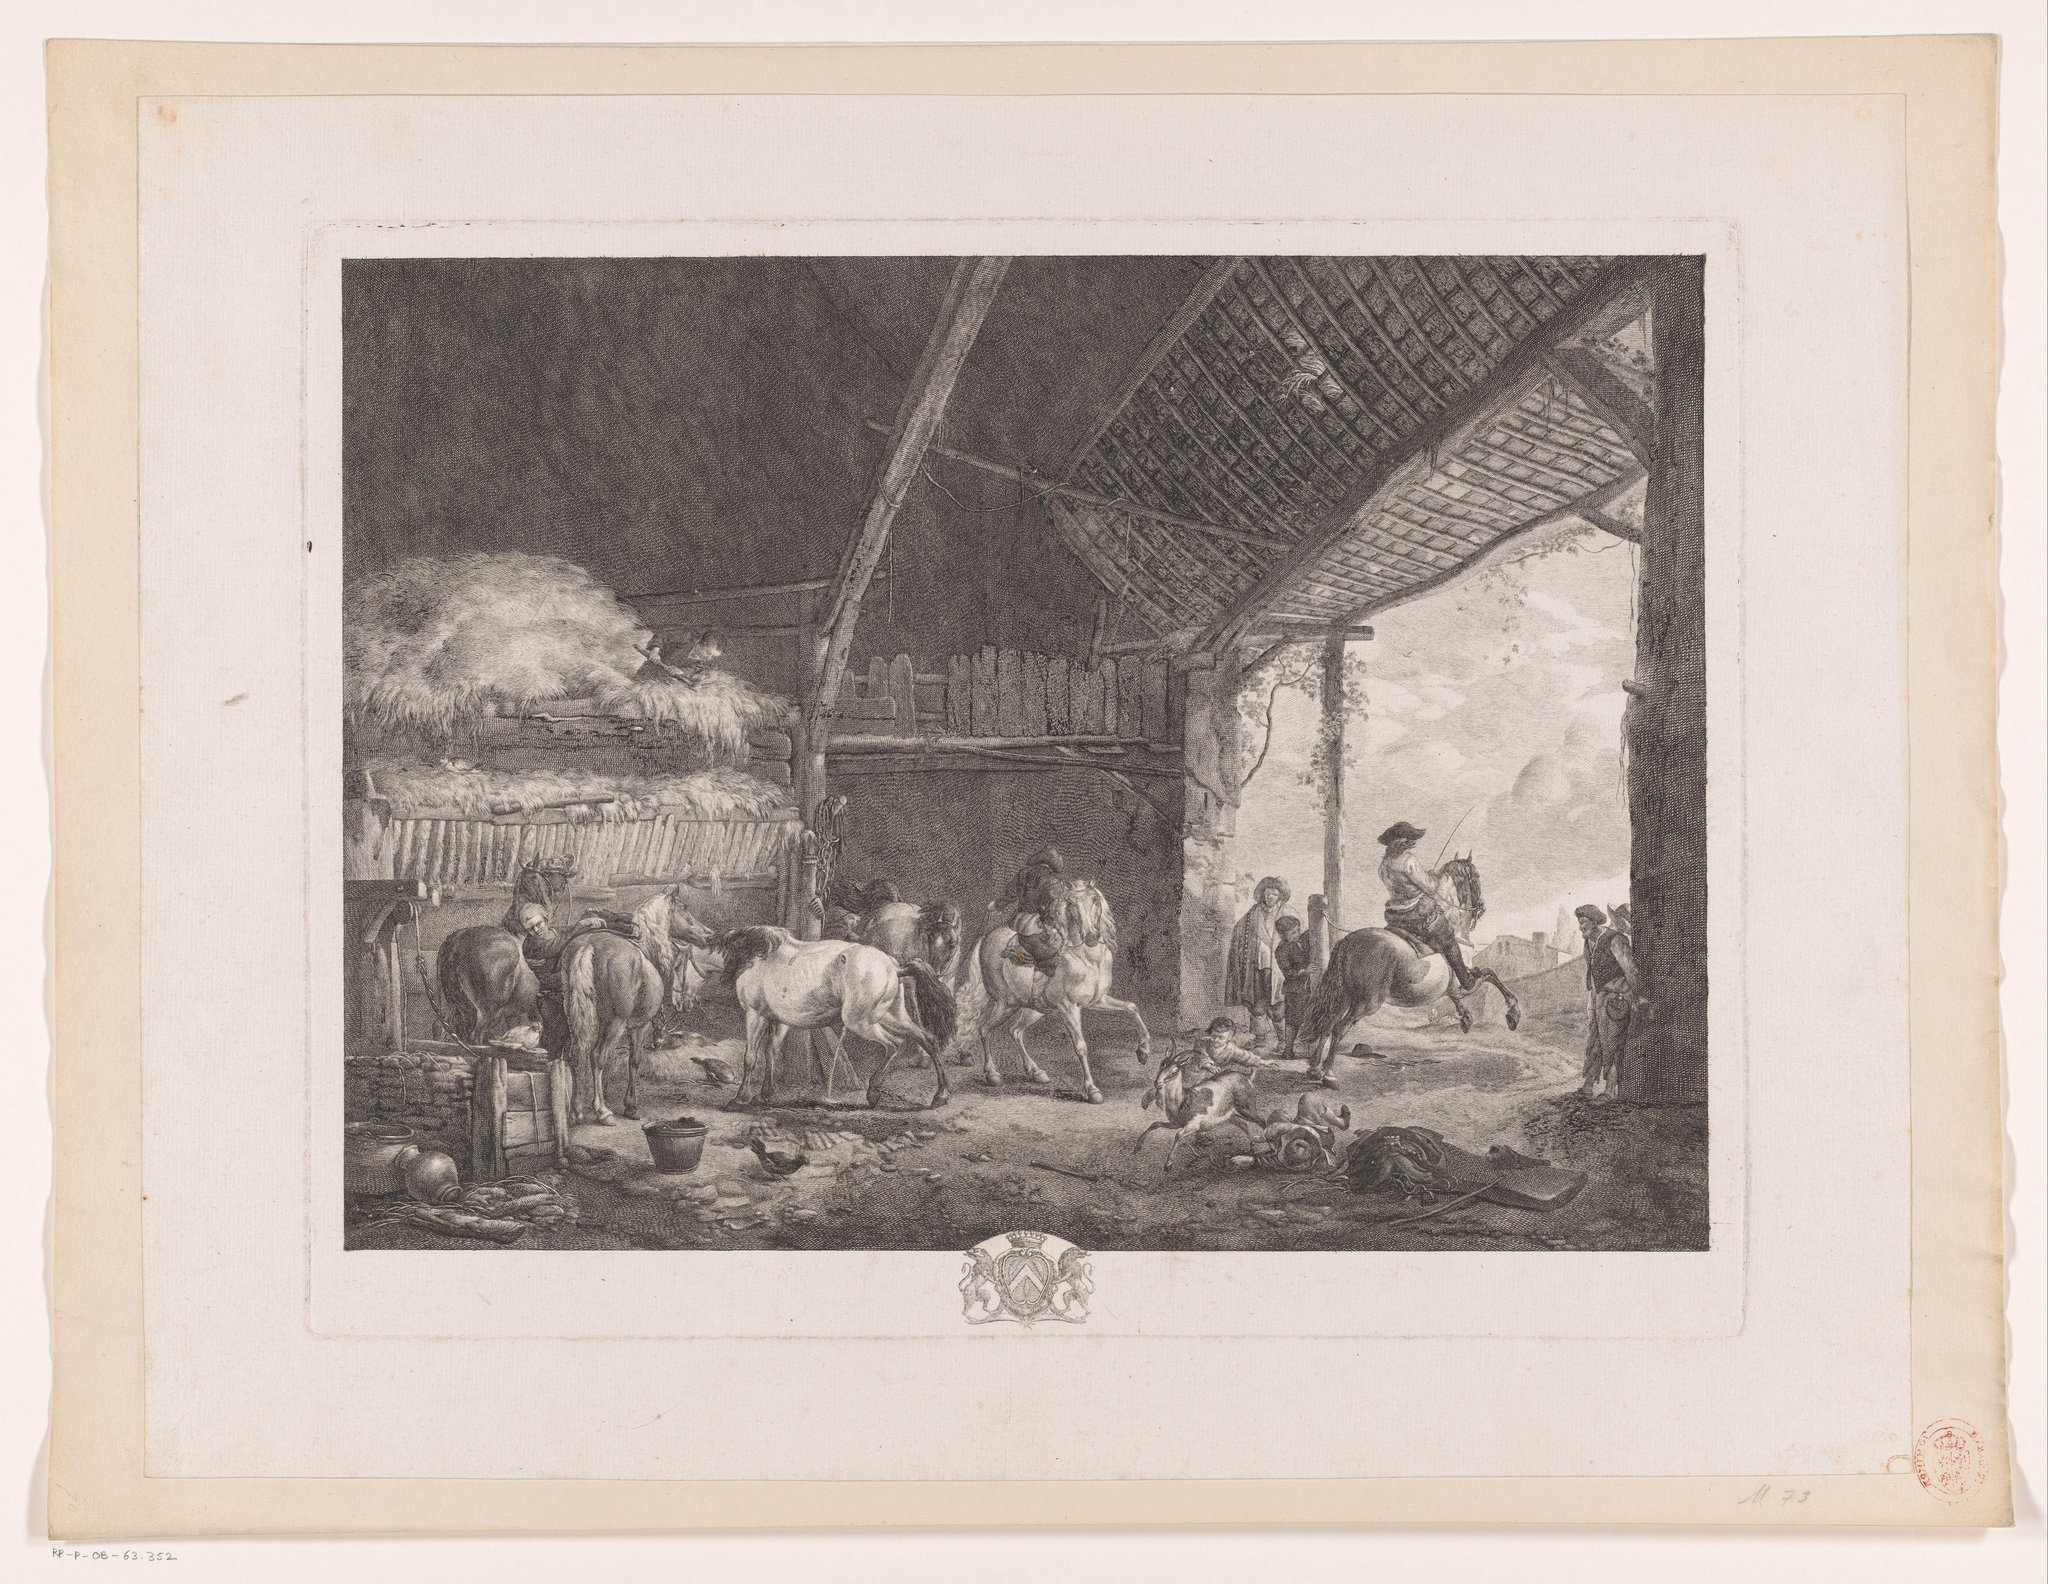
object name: print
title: L'Ecurie de la Poste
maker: jean moyreau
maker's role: print maker, publisher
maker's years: 1690-1762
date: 1753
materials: paper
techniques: engraving, etching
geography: france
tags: post-office, horse, stall, stable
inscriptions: collector's mark: Lugt 240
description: Maakt deel uit van een serie van 89 prenten te dateren tussen ca. 1733-1762, naar het geschilderde oeuvre van Philips Wouwerman. Dit betreft plaat 73.